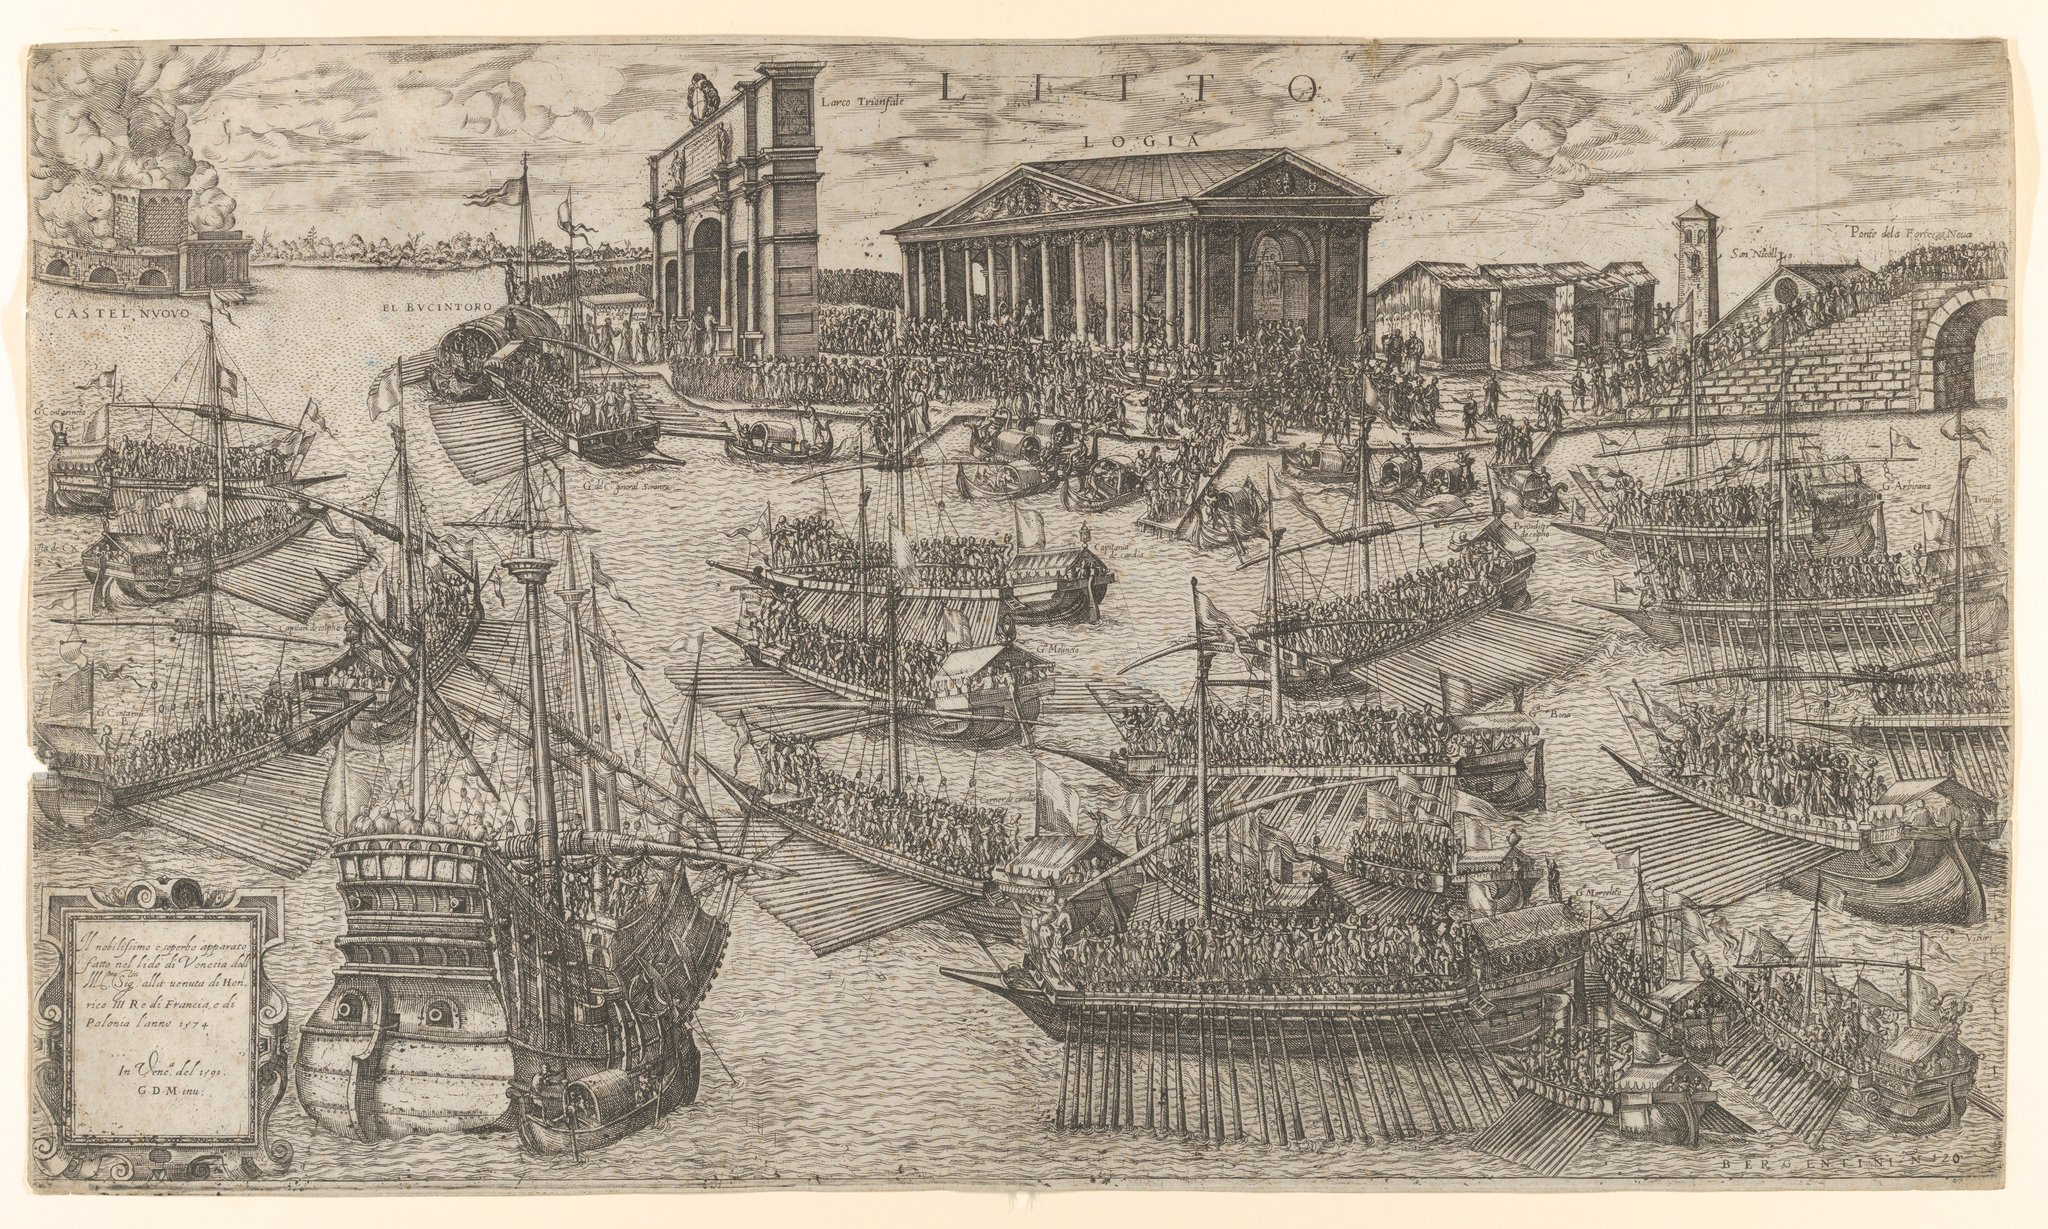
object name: print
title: The arrival of Henri III of France at the Lido in Venice in 1574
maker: Anonymous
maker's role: artist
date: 1591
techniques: engraving, etching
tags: canals,ships,venice